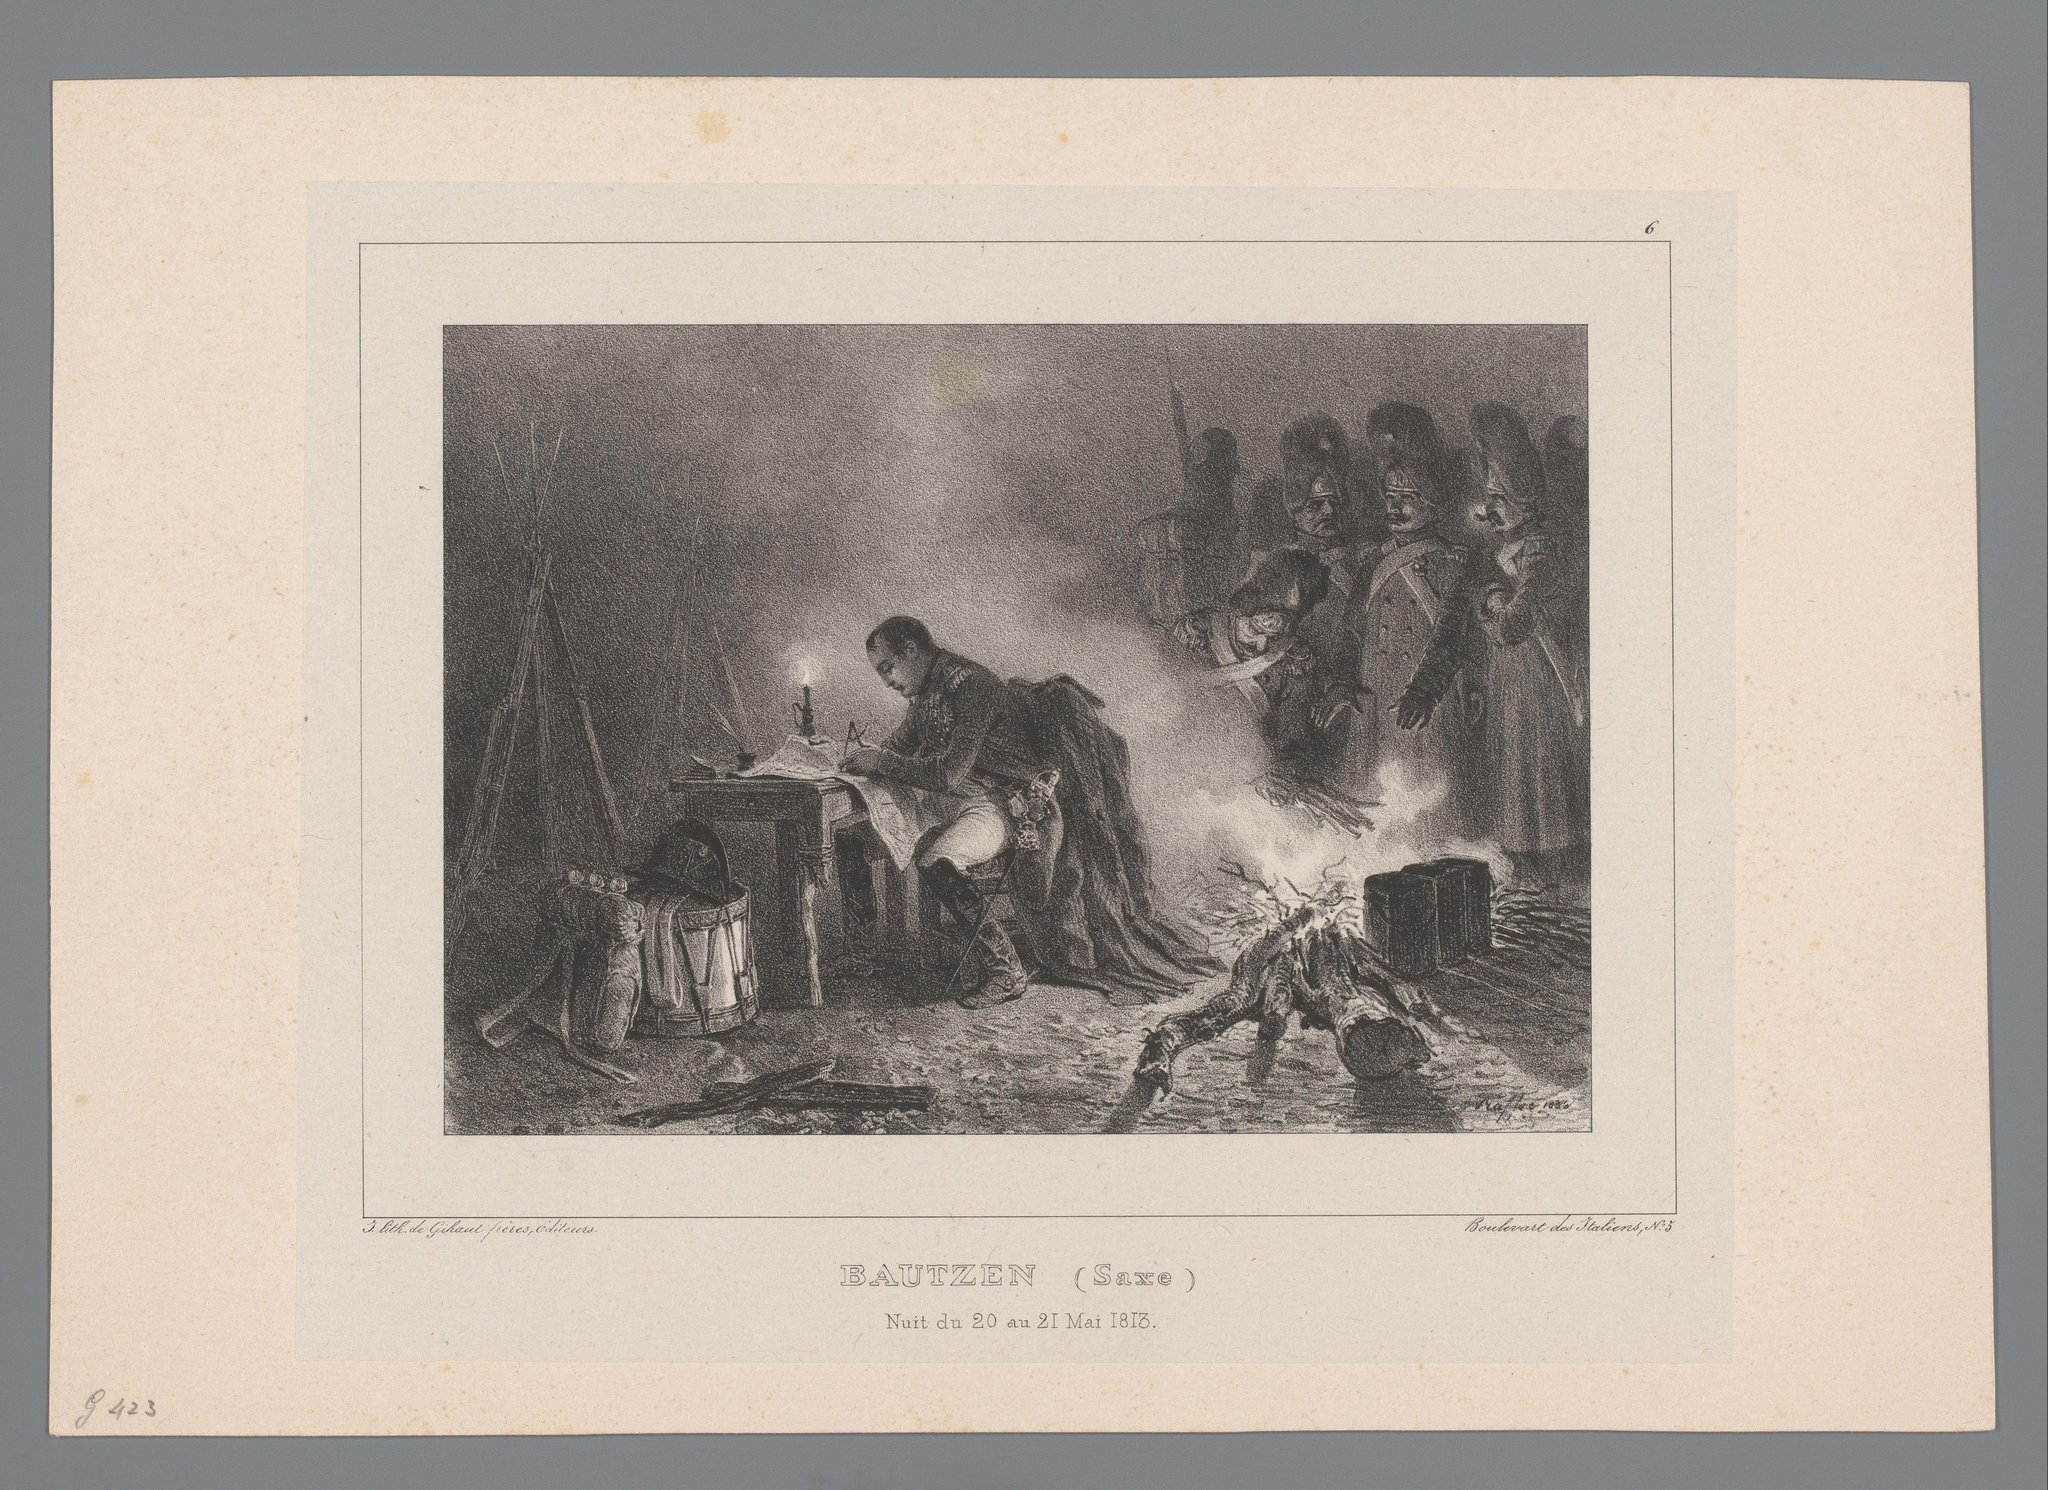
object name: print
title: Bautzen (Saxe), nuit du 20 au 21 mai 1813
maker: denis auguste marie raffet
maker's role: draughtsman, print maker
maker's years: 1804-1860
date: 1836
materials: paper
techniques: lithograph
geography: paris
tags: napoleon i (emperor of the french), emperor, the soldier; the soldier's life, charge ~ battle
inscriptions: collector's mark: Lugt 964